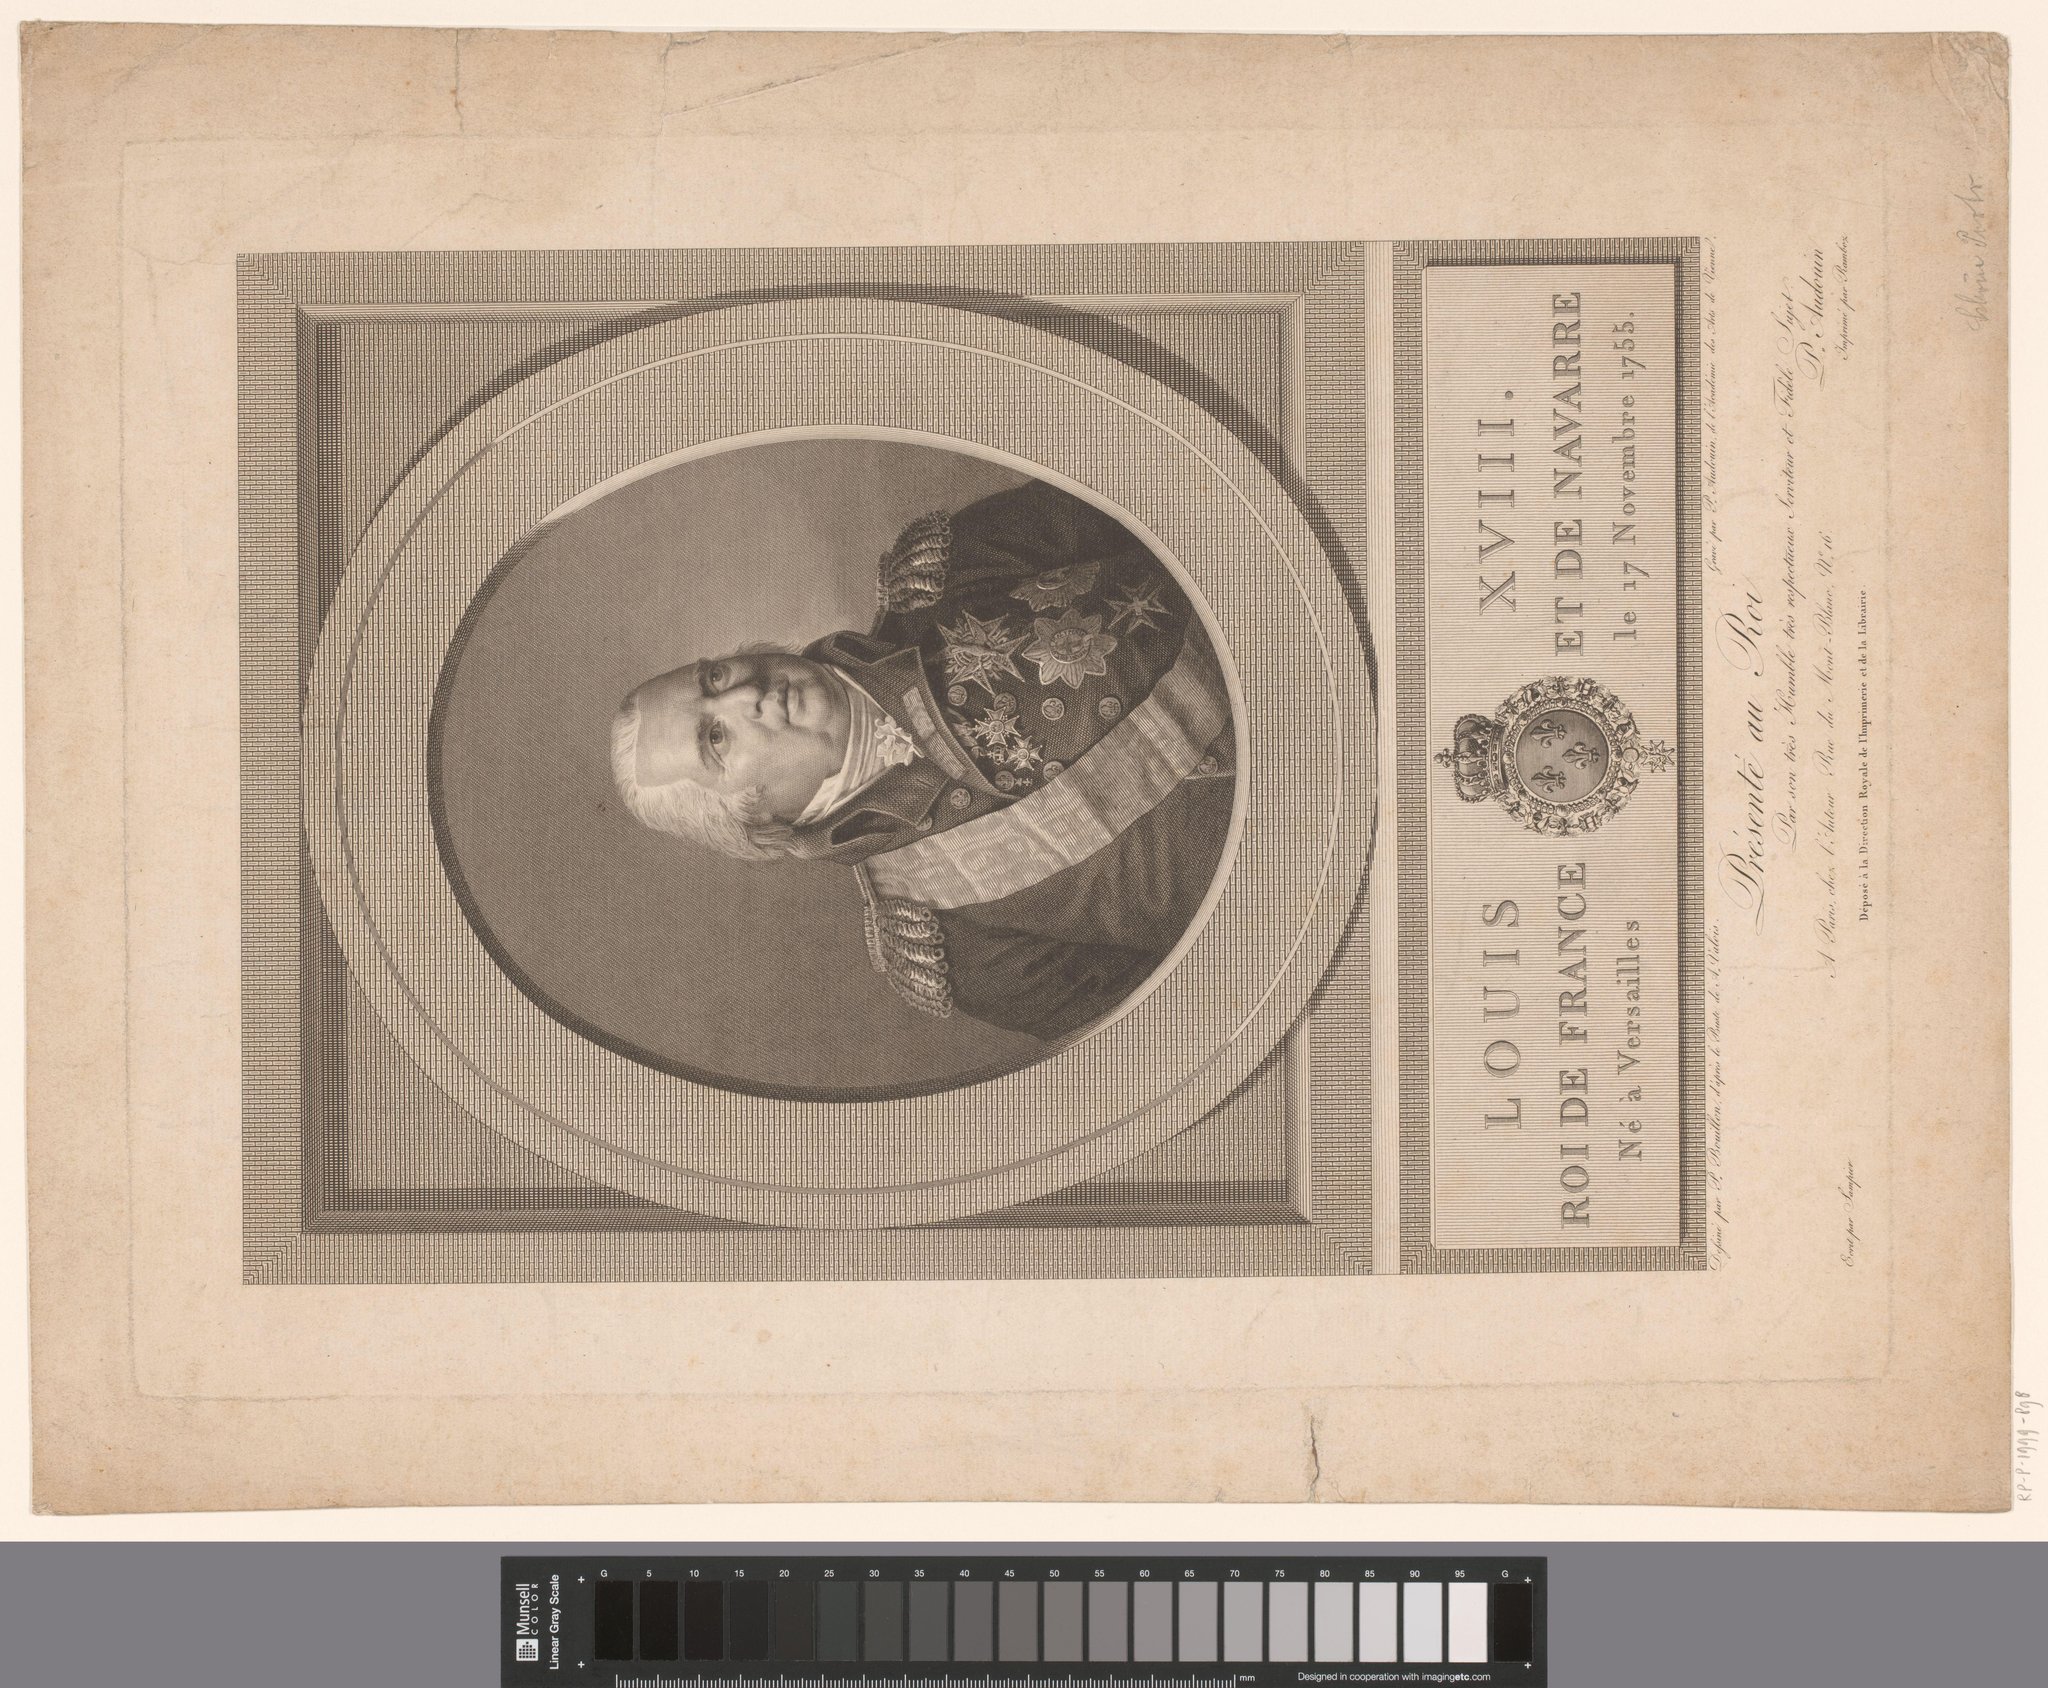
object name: print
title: Louis XVIII. Roi de France et de Navarre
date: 1817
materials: paper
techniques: engraving, etching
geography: france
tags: paris, lodewijk xviii (koning van frankrijk), historical persons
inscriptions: collector's mark: Lugt 2228, collector's mark: Lugt 2760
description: Portret maakte deel uit van een serie van negen portretten.